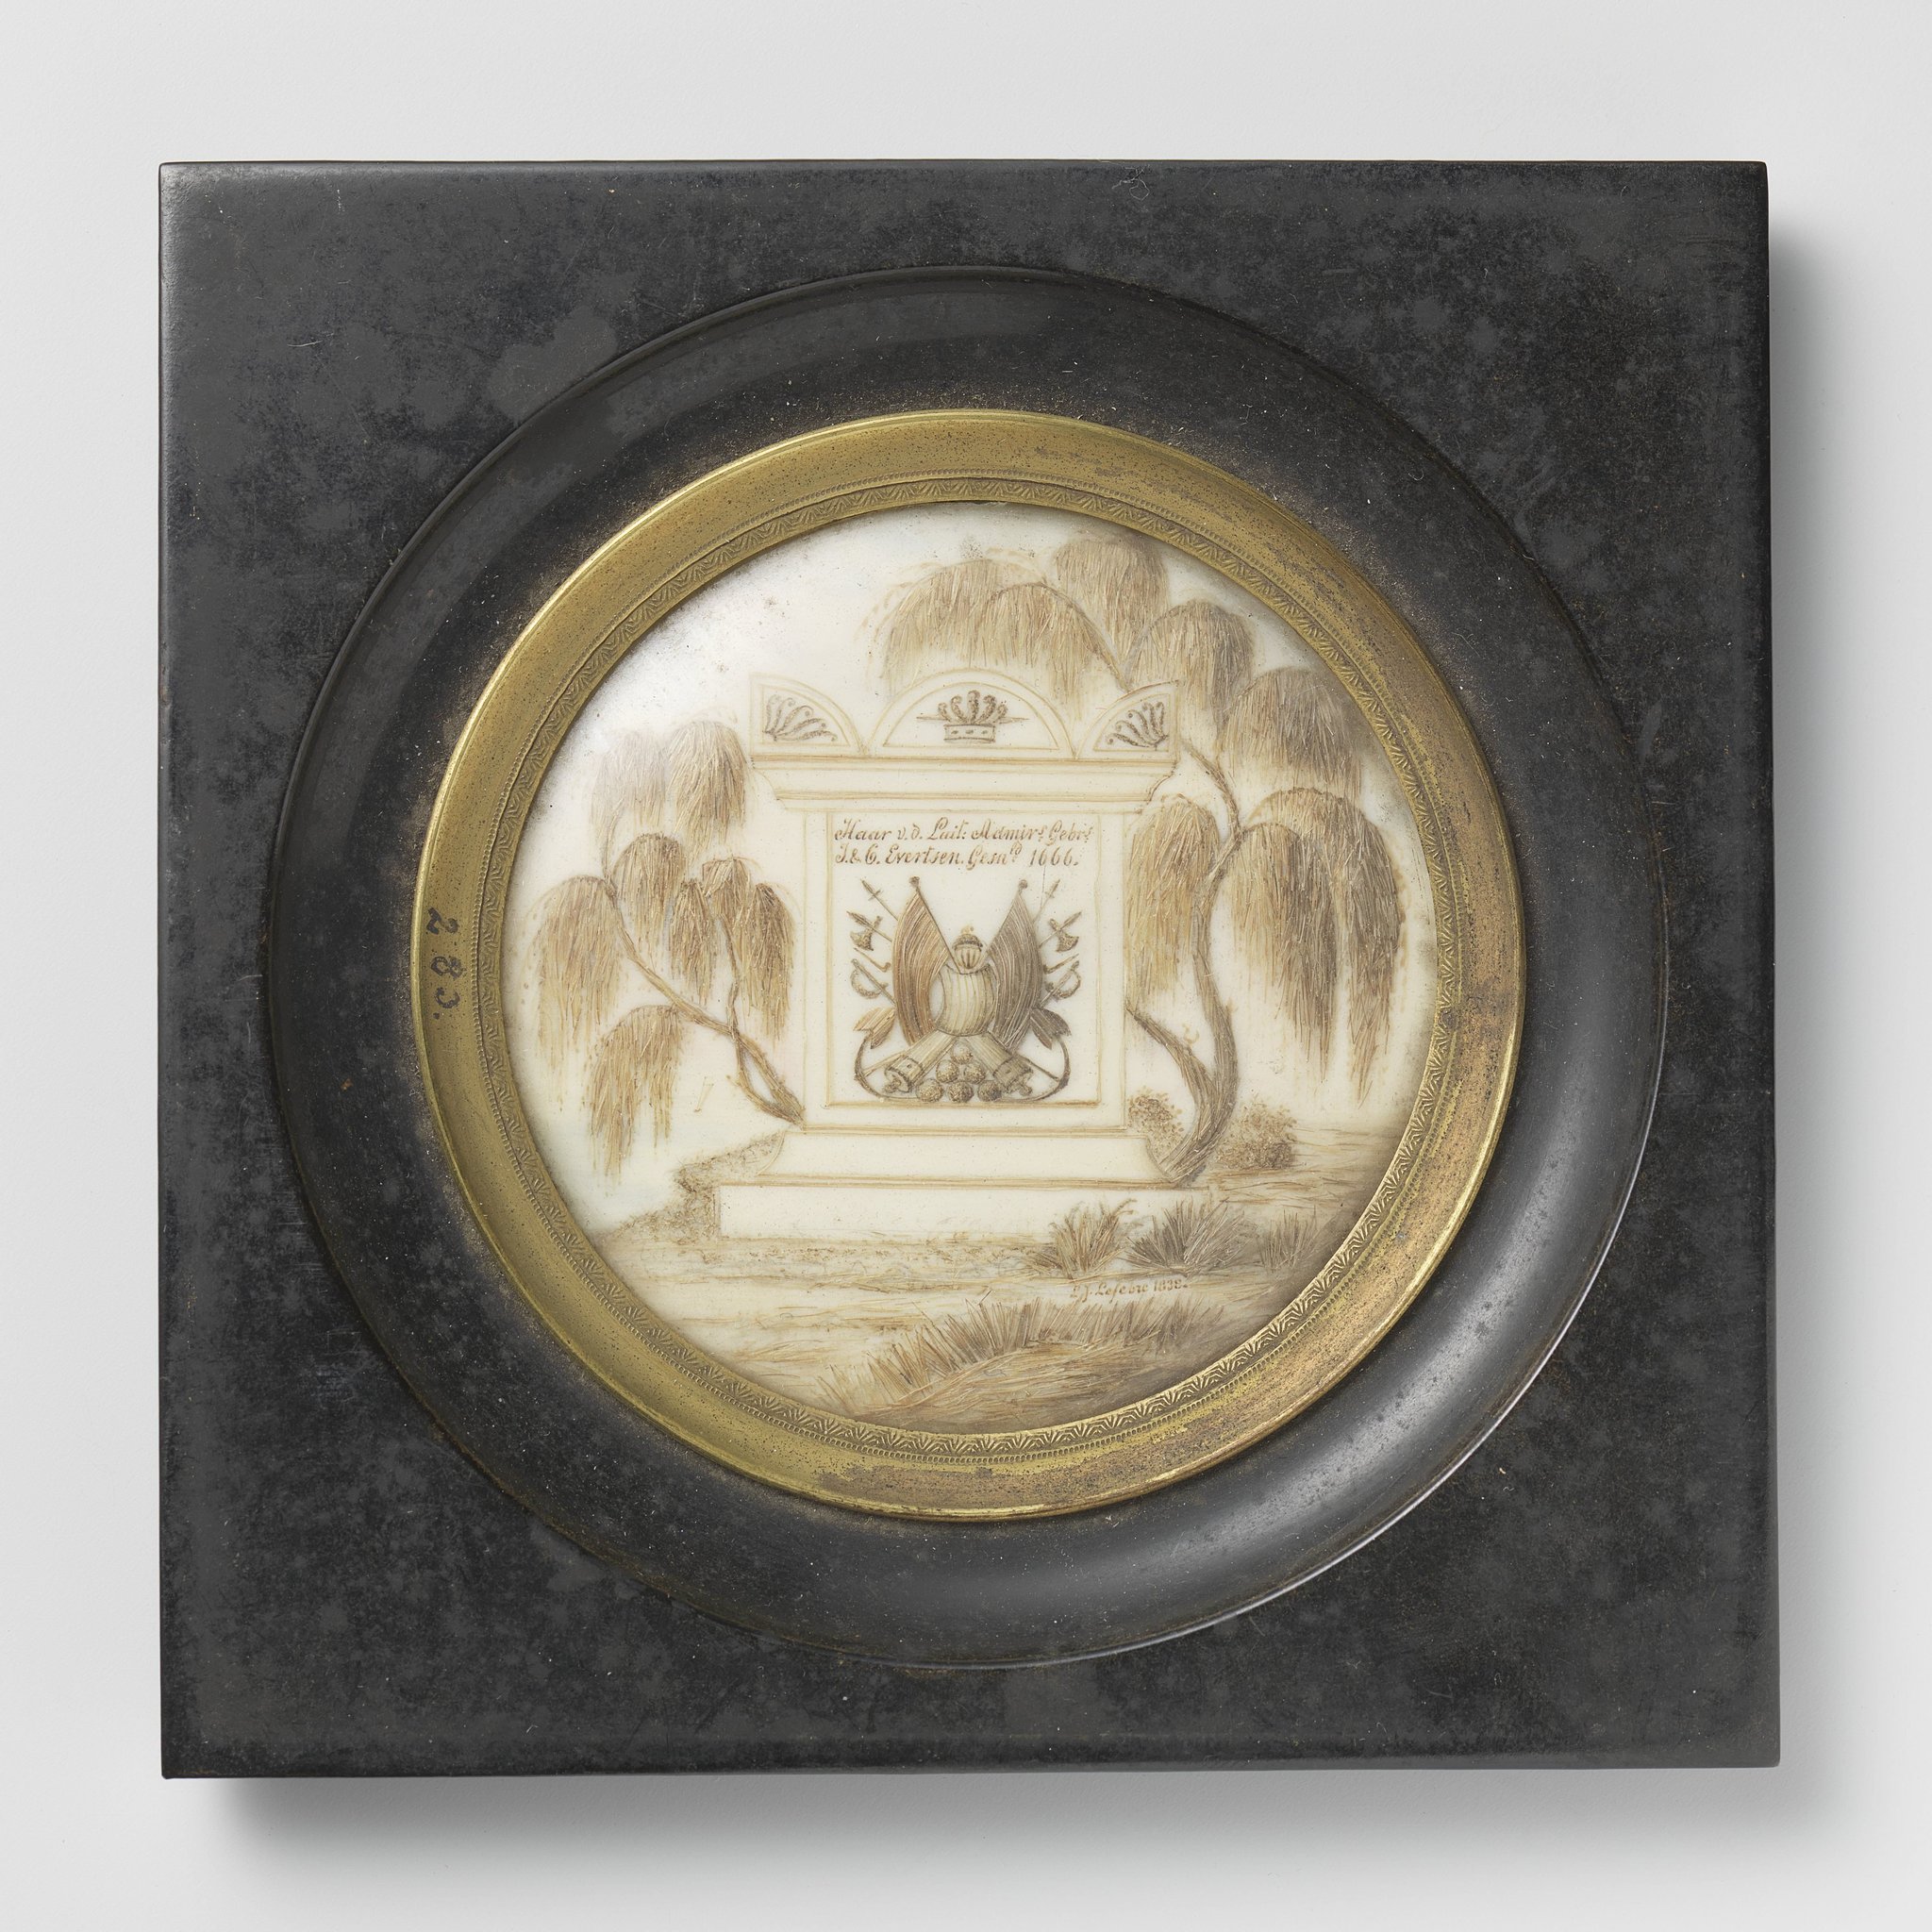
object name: commemorative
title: Haar van de luitenant admiraals gebroeders J. & C. Evertsen, gesneuveld 1666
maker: l.j. lefèbre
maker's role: constructeur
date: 1838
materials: copper, glass, hair, ivory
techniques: framing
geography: netherlands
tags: flushing, other memorial structures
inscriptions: : ‘Haar v.d. Luit: Admiraals. Gebrs. J & C. Evertsen. Gesneuveld 1666.’, date: ‘1838’, signature: ‘L. J. Lefebre’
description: Van menselijk haar gemaakte voorstelling van een monument met opschrift en wapentrofeeën op de voorzijde en op de bovenkant een kroon in halfrond cartouche, op voet; ter weerszijden een boom met naar beneden hangende twijgen. Rond. Gevat in stenen vierkanten lijst met koperkleurige metalen binnenkant. Gesigneerd, gedateerd en met opschrift.